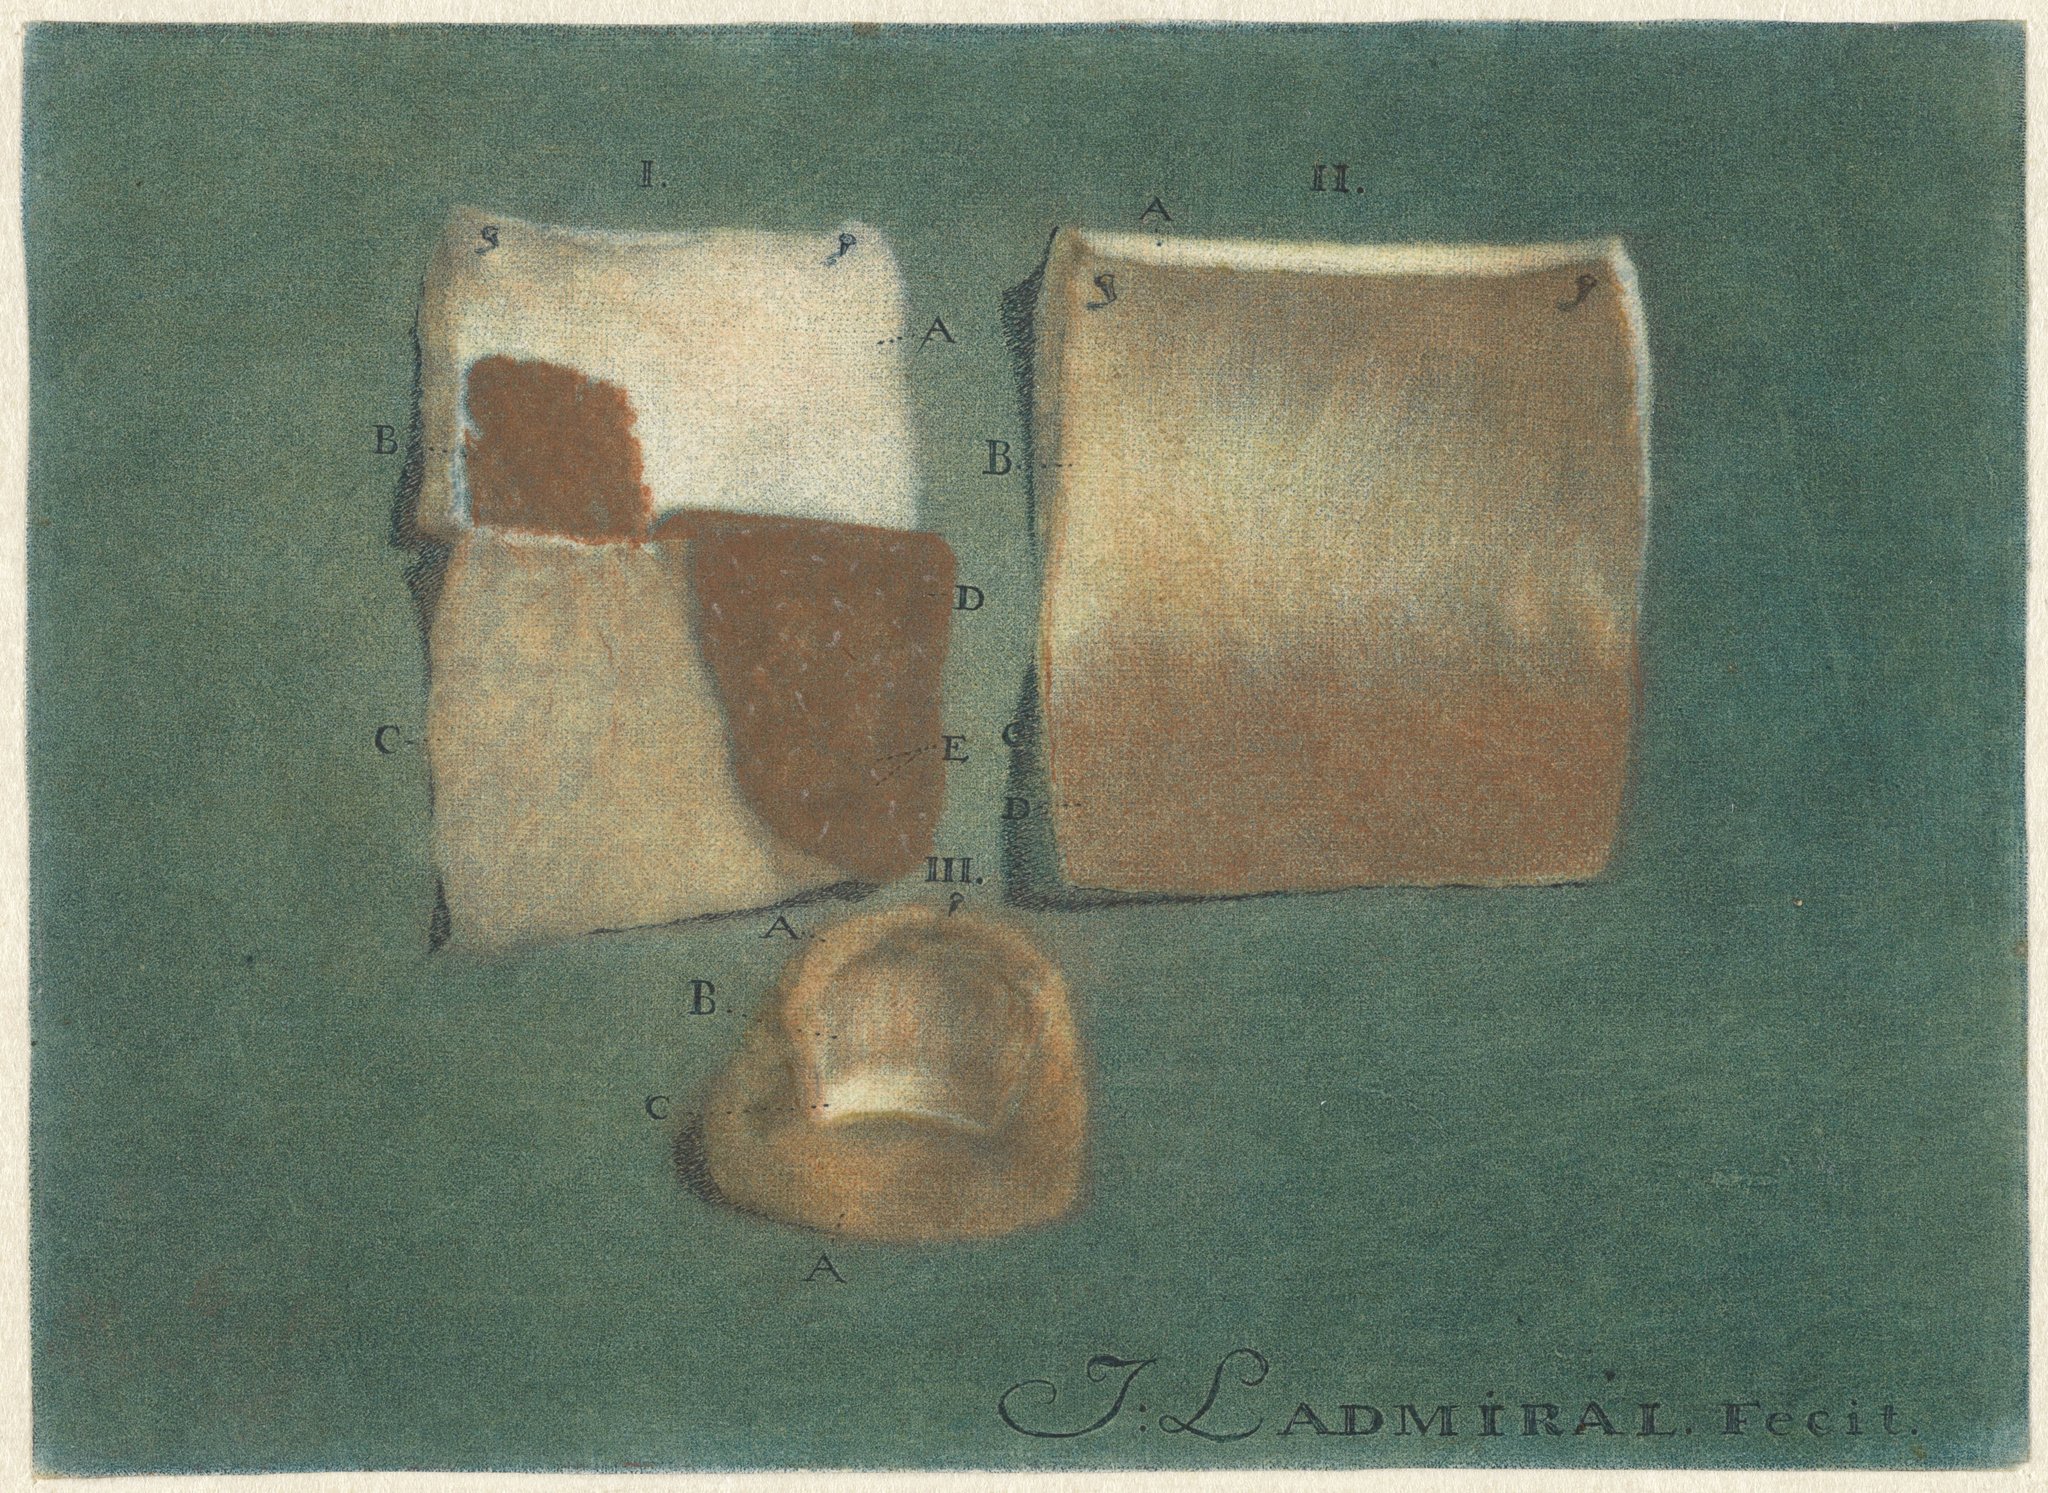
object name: print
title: Anatomische studie van menselijke huid en nagel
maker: jan l admiral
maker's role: draughtsman, print maker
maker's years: 1699-1773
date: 1737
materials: paper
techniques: hand coloring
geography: amsterdam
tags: other anatomical details, skin (human), nails (fingers)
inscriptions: collector's mark: Lugt 2233, collector's mark: Lugt 2228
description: Jan L'Admiral gebruikte voor de groep mezzotinten met het onderwerp 'Anatomische studie van menselijke huid en nagel' vier verschillende platen: A, B, C en D. Proefdruk voor illustratie in: Albinus, Bernhard Siegfried. Dissertatio secunda. De sede et caussa coloris Aethiopum et caeterorum hominum, Leiden: Dirk Haak (II) en Amsterdam: Jacob Graal en Hendrik de Leth, 1737.